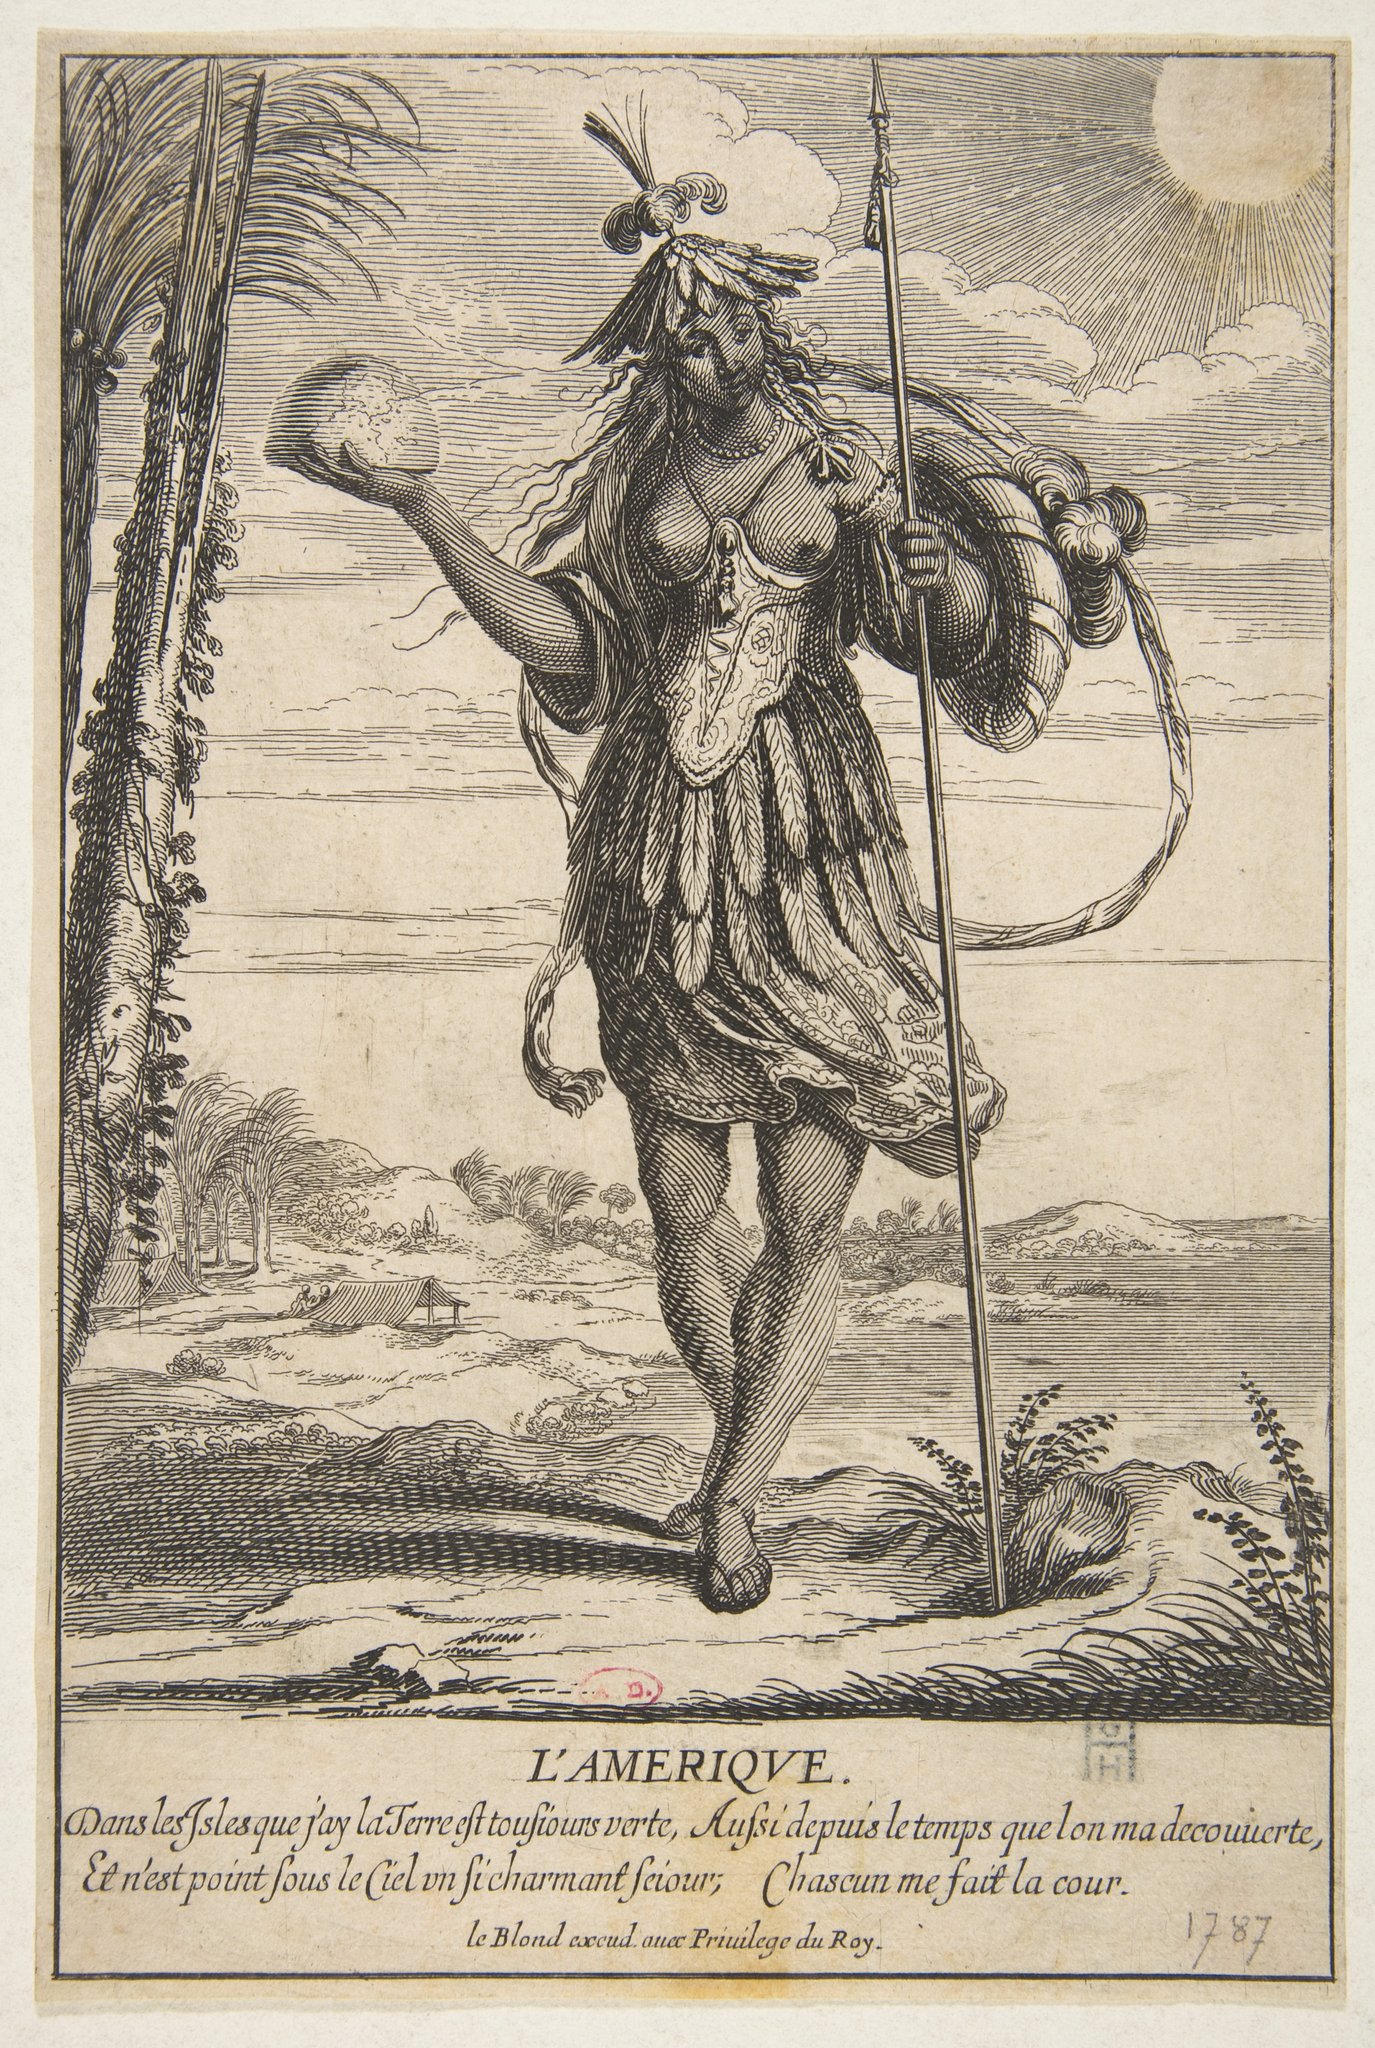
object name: print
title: Allegory of America, from "The Four Continents"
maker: abraham bosse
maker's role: artist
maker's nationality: french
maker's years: 1602-1676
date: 1602-1676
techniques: etching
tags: spears,women